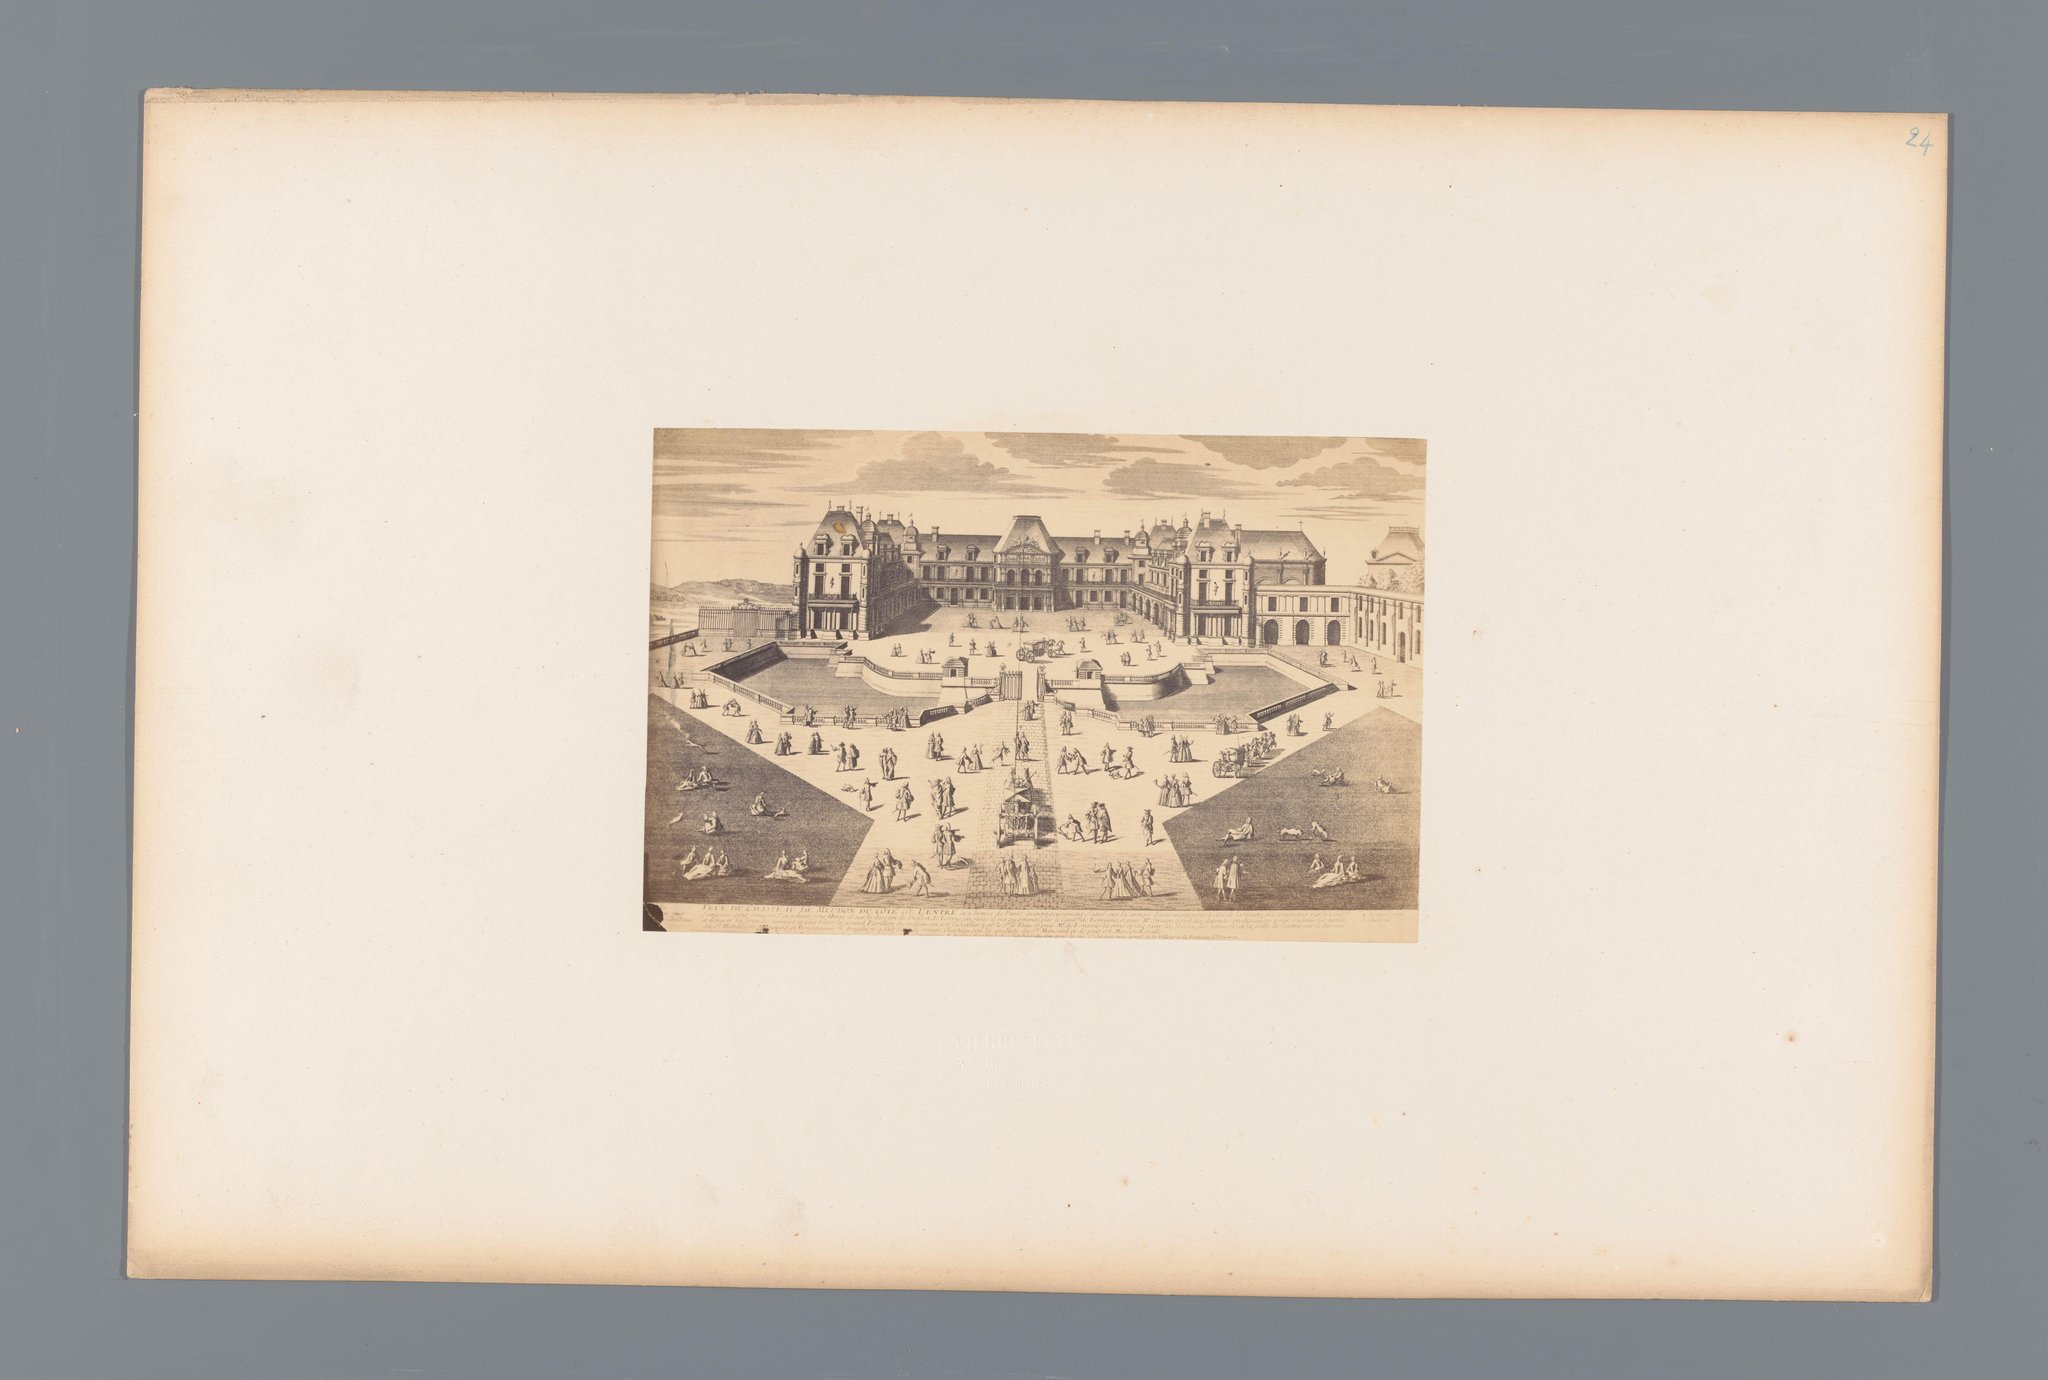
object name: reproduction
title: Fotoreproductie van een ontwerp van een gezicht op het kasteel van Meudon, gezien vanaf de ingang van het landgoed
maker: pierre petit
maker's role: fotograaf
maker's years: 1832-1909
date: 1860-1865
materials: photographic support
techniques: albumen print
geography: paris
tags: castle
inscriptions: check stamp: ‘PHOTOGRAPHIE des DEUX MONDES/ PIERRE PETIT/ 31, Rue Cadet, 31/ PARIS’, number: ‘24’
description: Deze foto maakt deel uit van een omslag met 38 foto's en 17 tekstbladen.